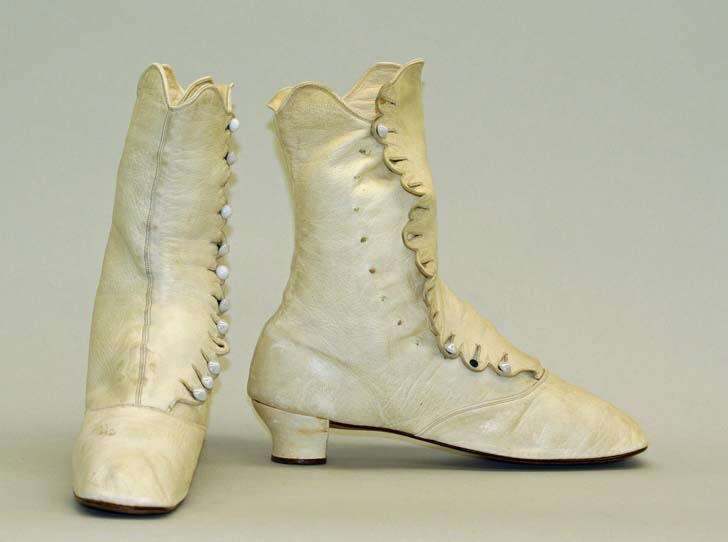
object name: wedding accessory set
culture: american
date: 1872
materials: leather